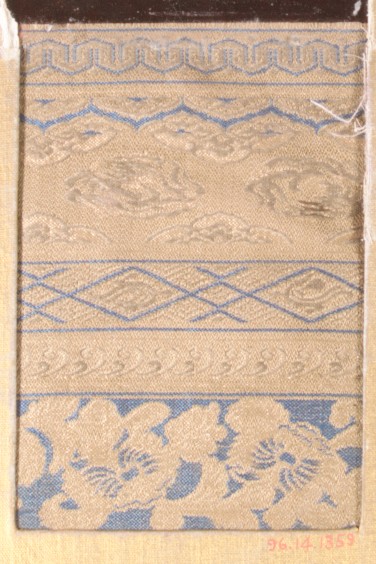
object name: piece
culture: japanese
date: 1701-1900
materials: silk